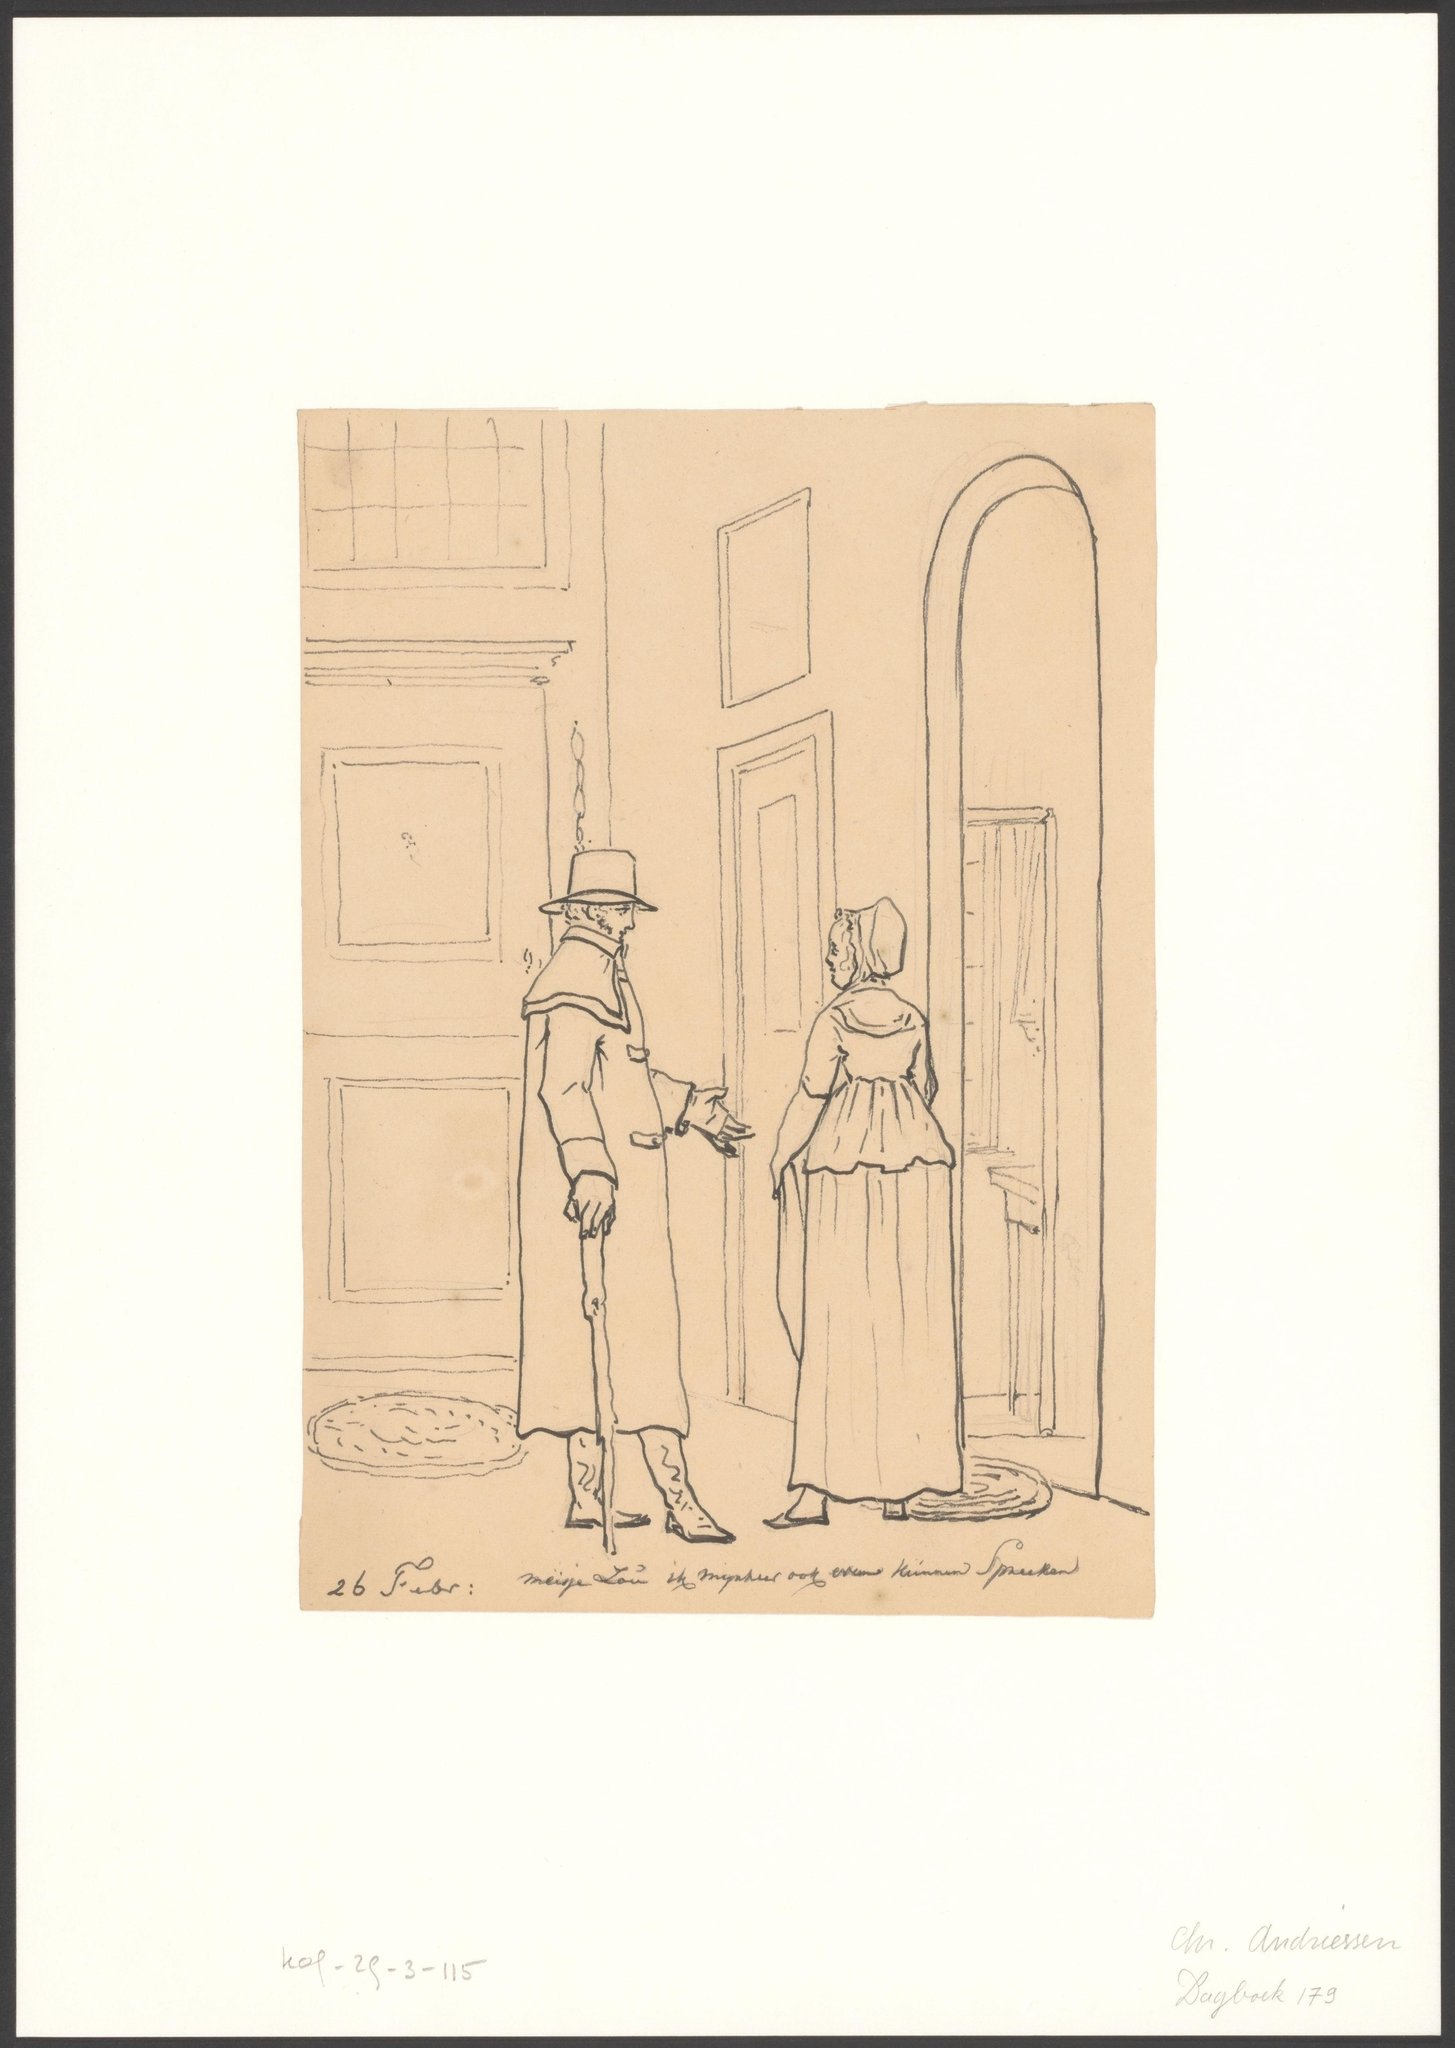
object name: drawing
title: Christiaan Andriessen vraagt of hij een man kan spreken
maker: christiaan andriessen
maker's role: draughtsman, print maker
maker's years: 1775-1846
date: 1805-1808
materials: ink, paper, pencil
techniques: pen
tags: amsterdam, print maker, draughtsman, christiaan andriessen, vestibule, hall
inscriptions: signature: ‘J Andriessen’, inscription: ‘26 Febr: meisje Zou ik mijnheer ook even kunnen Spreeken’, collector's mark: Lugt 1641, collector's mark: Lugt 1641a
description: Dagboekblad uit het getekende dagboek dat Christiaan Andriessen bijhield van 1805 tot en met 1808.